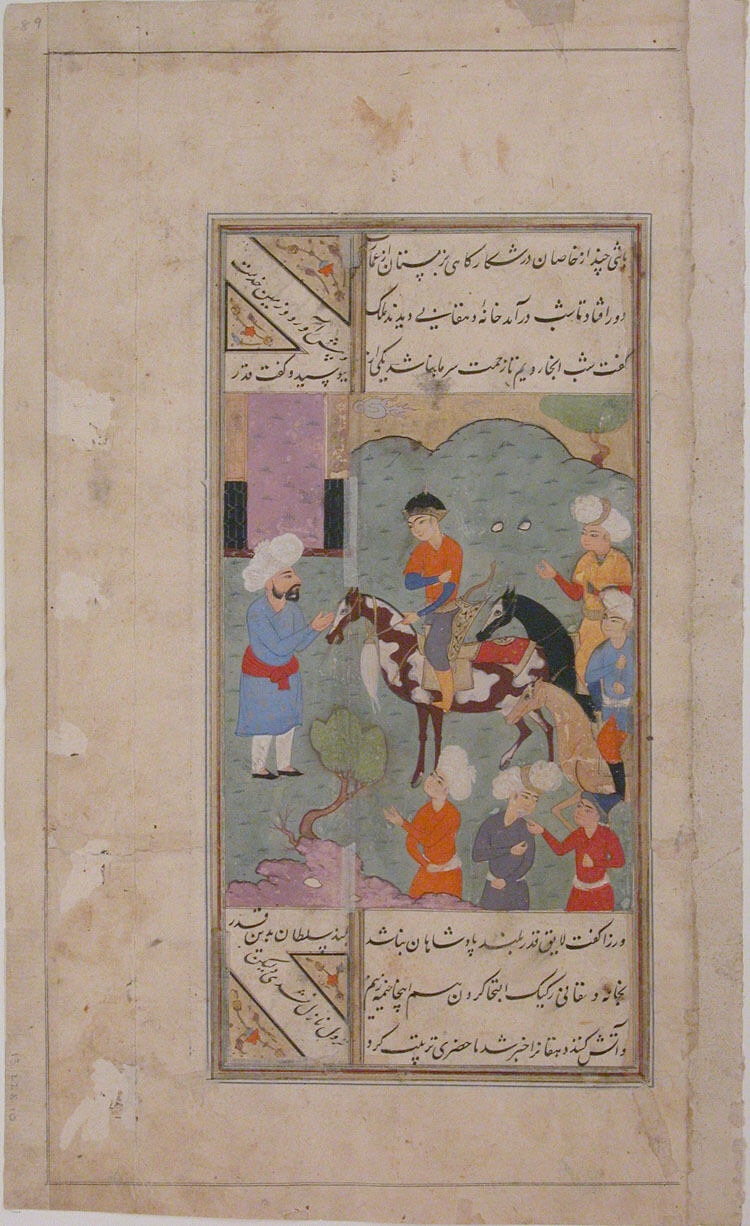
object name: folio from an illustrated manuscript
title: "The Head of the Village Thanks the King for Accepting his Humble Hospitality", Folio from a Kulliyat (Complete Works) of Sa'di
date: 1801-1900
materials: gold, ink, paper, watercolor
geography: india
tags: kings,horses